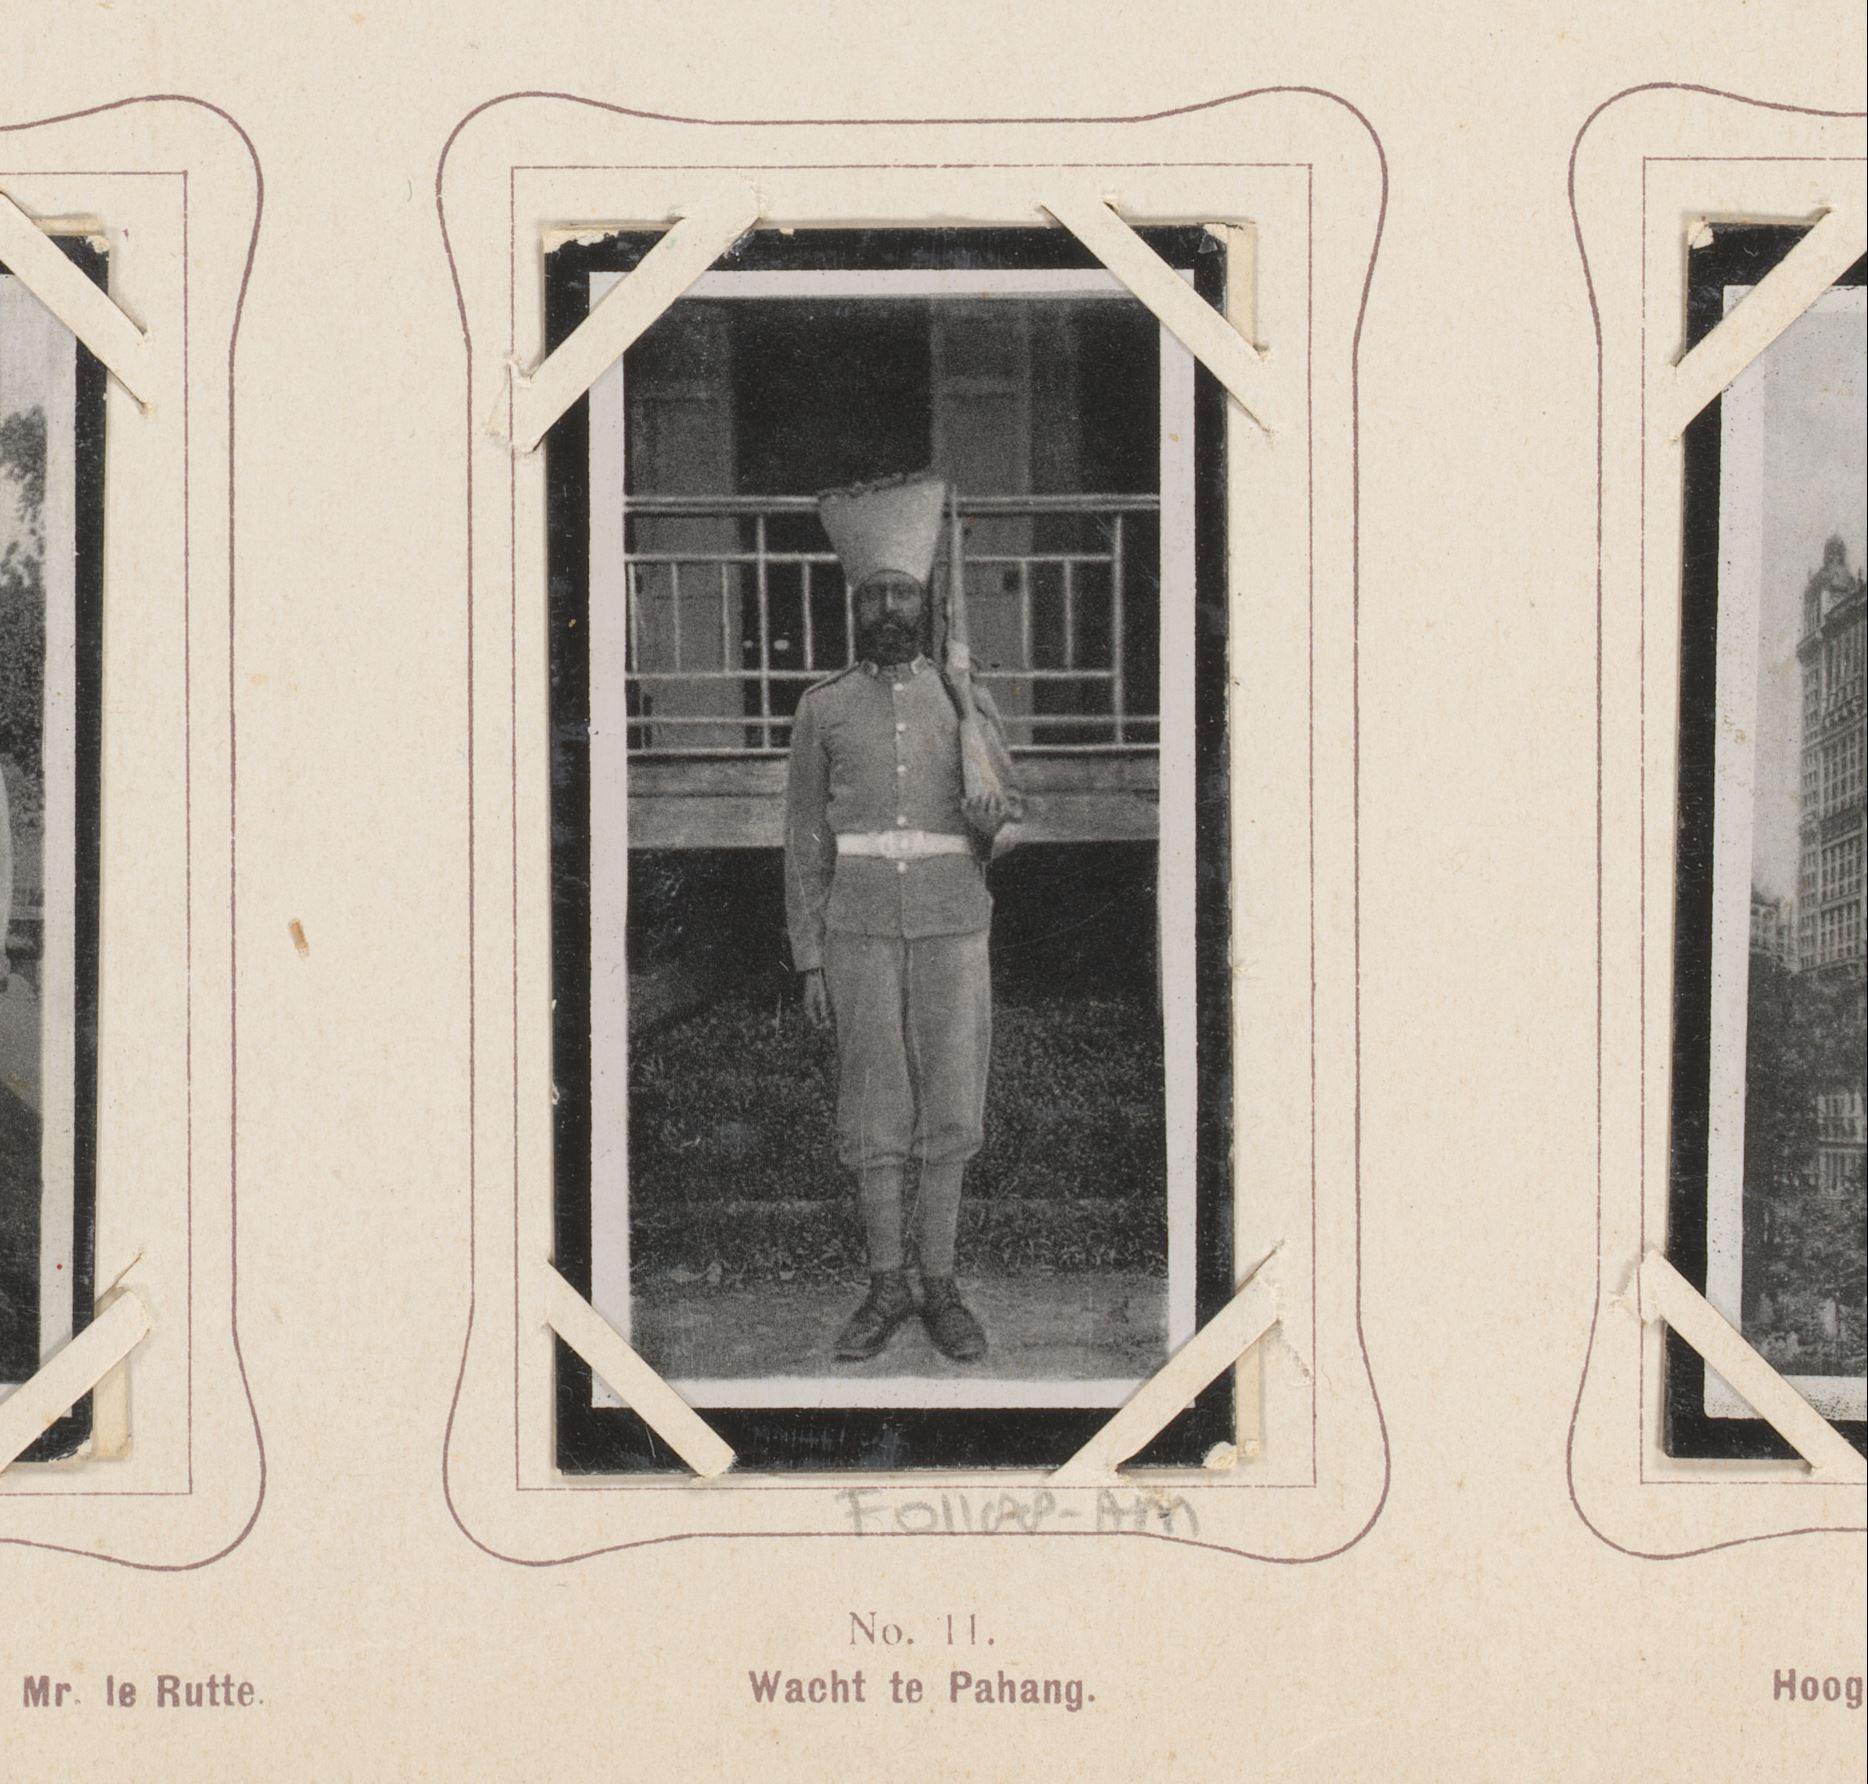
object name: album leaf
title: Portret van een Maleisische wachter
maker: Anonymous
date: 1906-1907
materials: paper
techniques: photograph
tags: historical persons, guard duty, keeping sentry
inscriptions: inscription: ‘No. 11./ Wacht te Pahang.’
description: Deze prent maakt deel uit van een album.